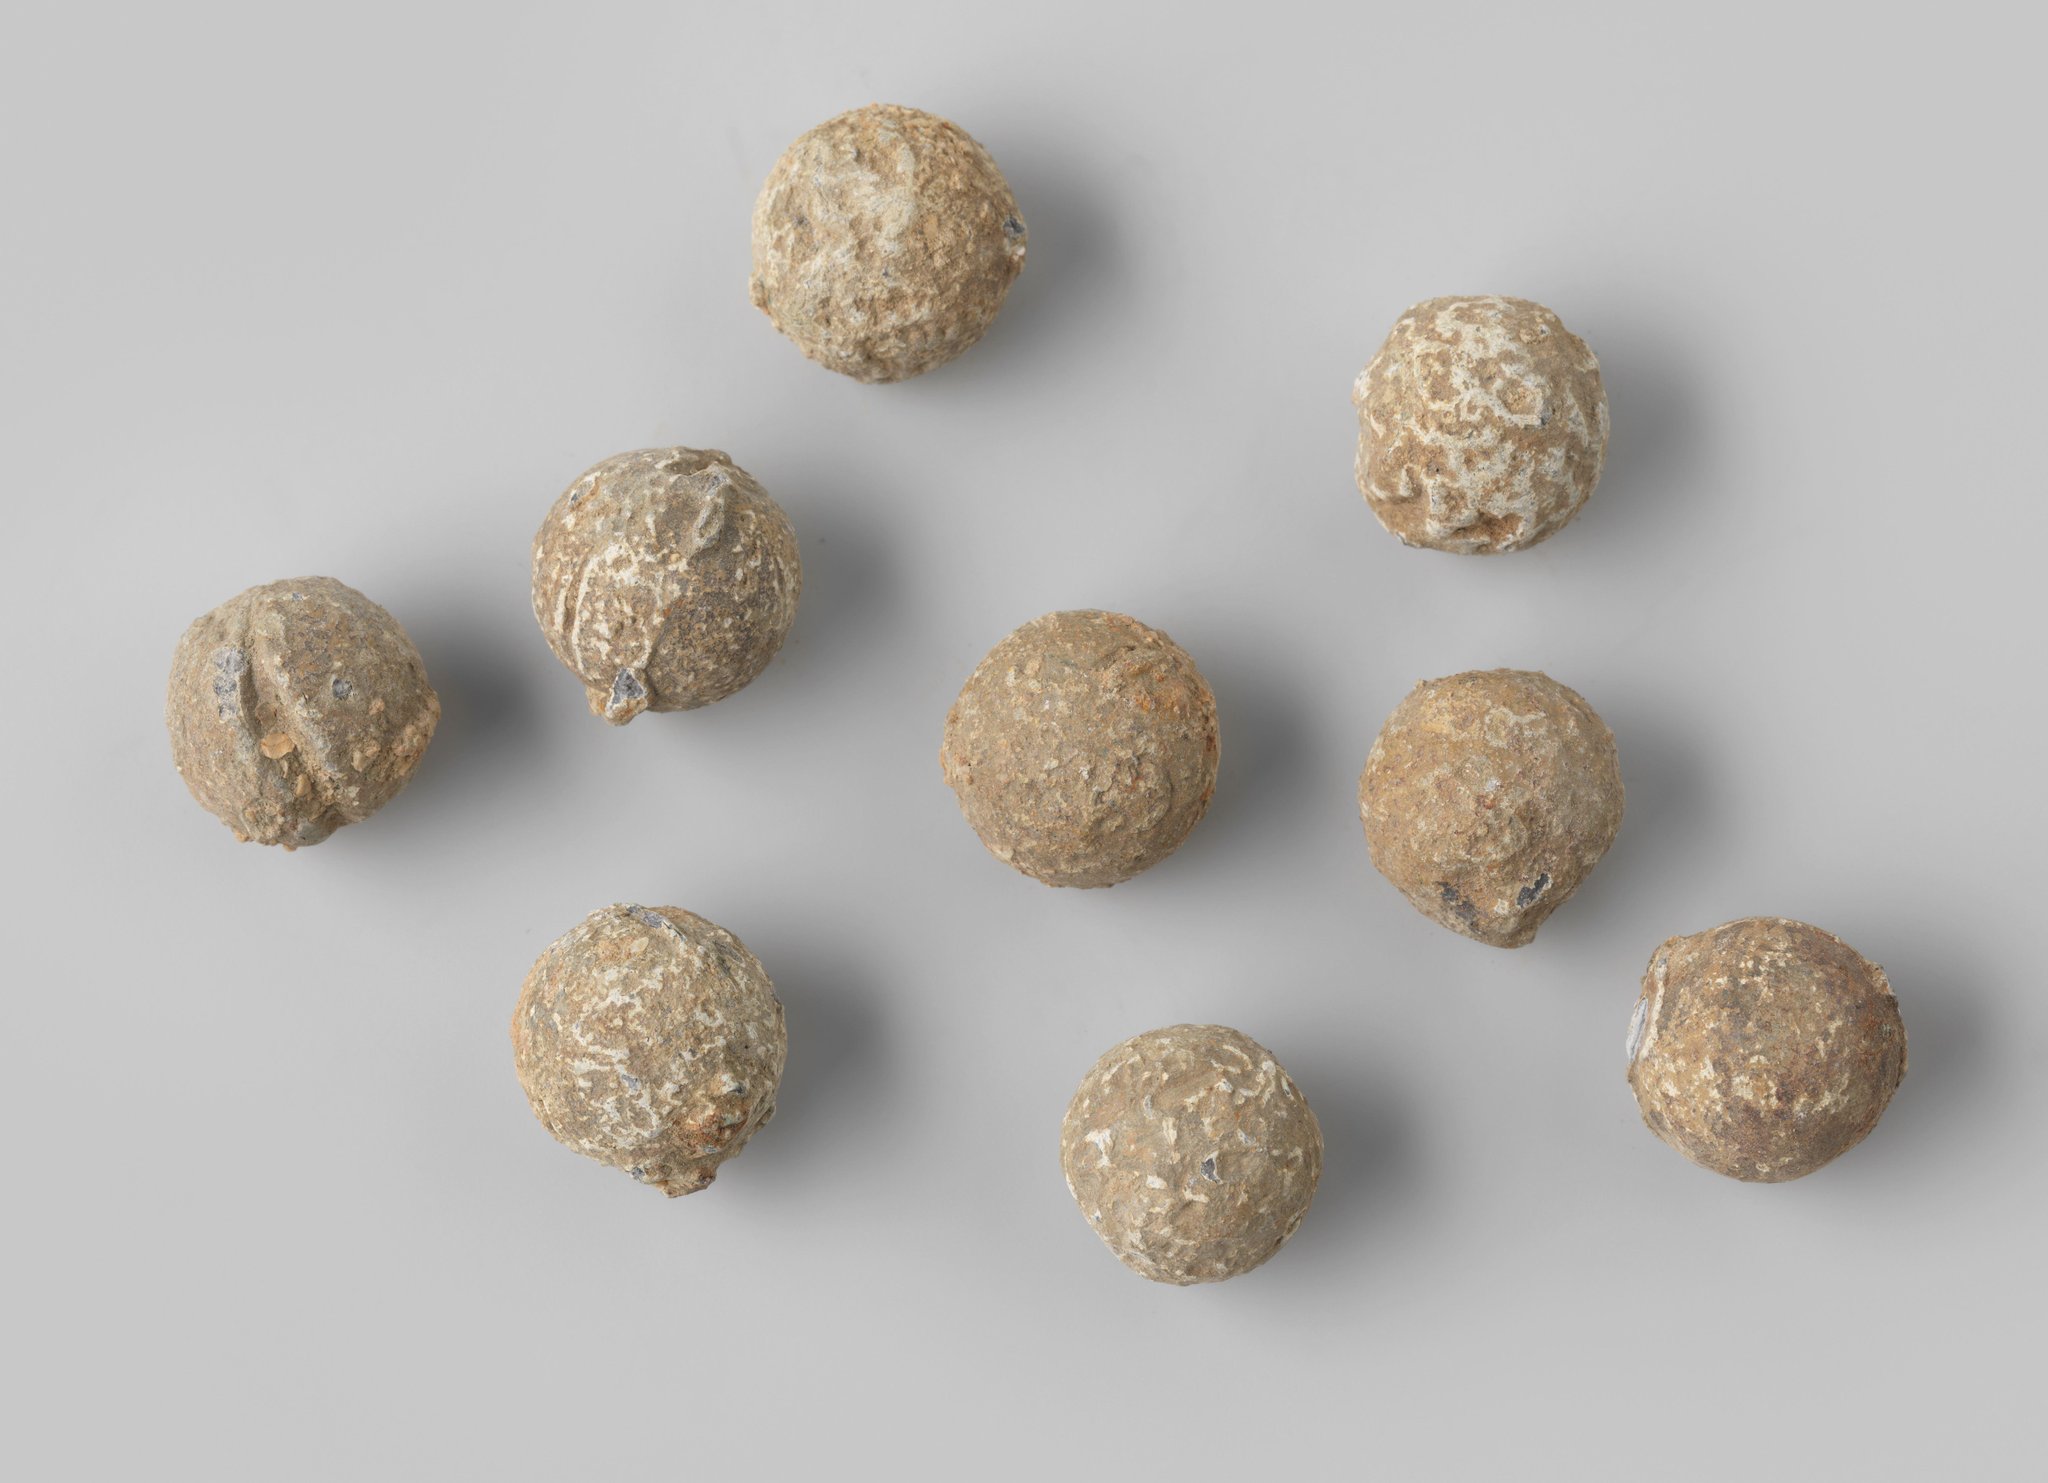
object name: musketkogel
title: Musketkogels uit het wrak van de Oost-Indiëvaarder Hollandia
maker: Anonymous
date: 1700-1743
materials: lead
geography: netherlands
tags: verenigde oostindische compagnie, hollandia (schip), annet